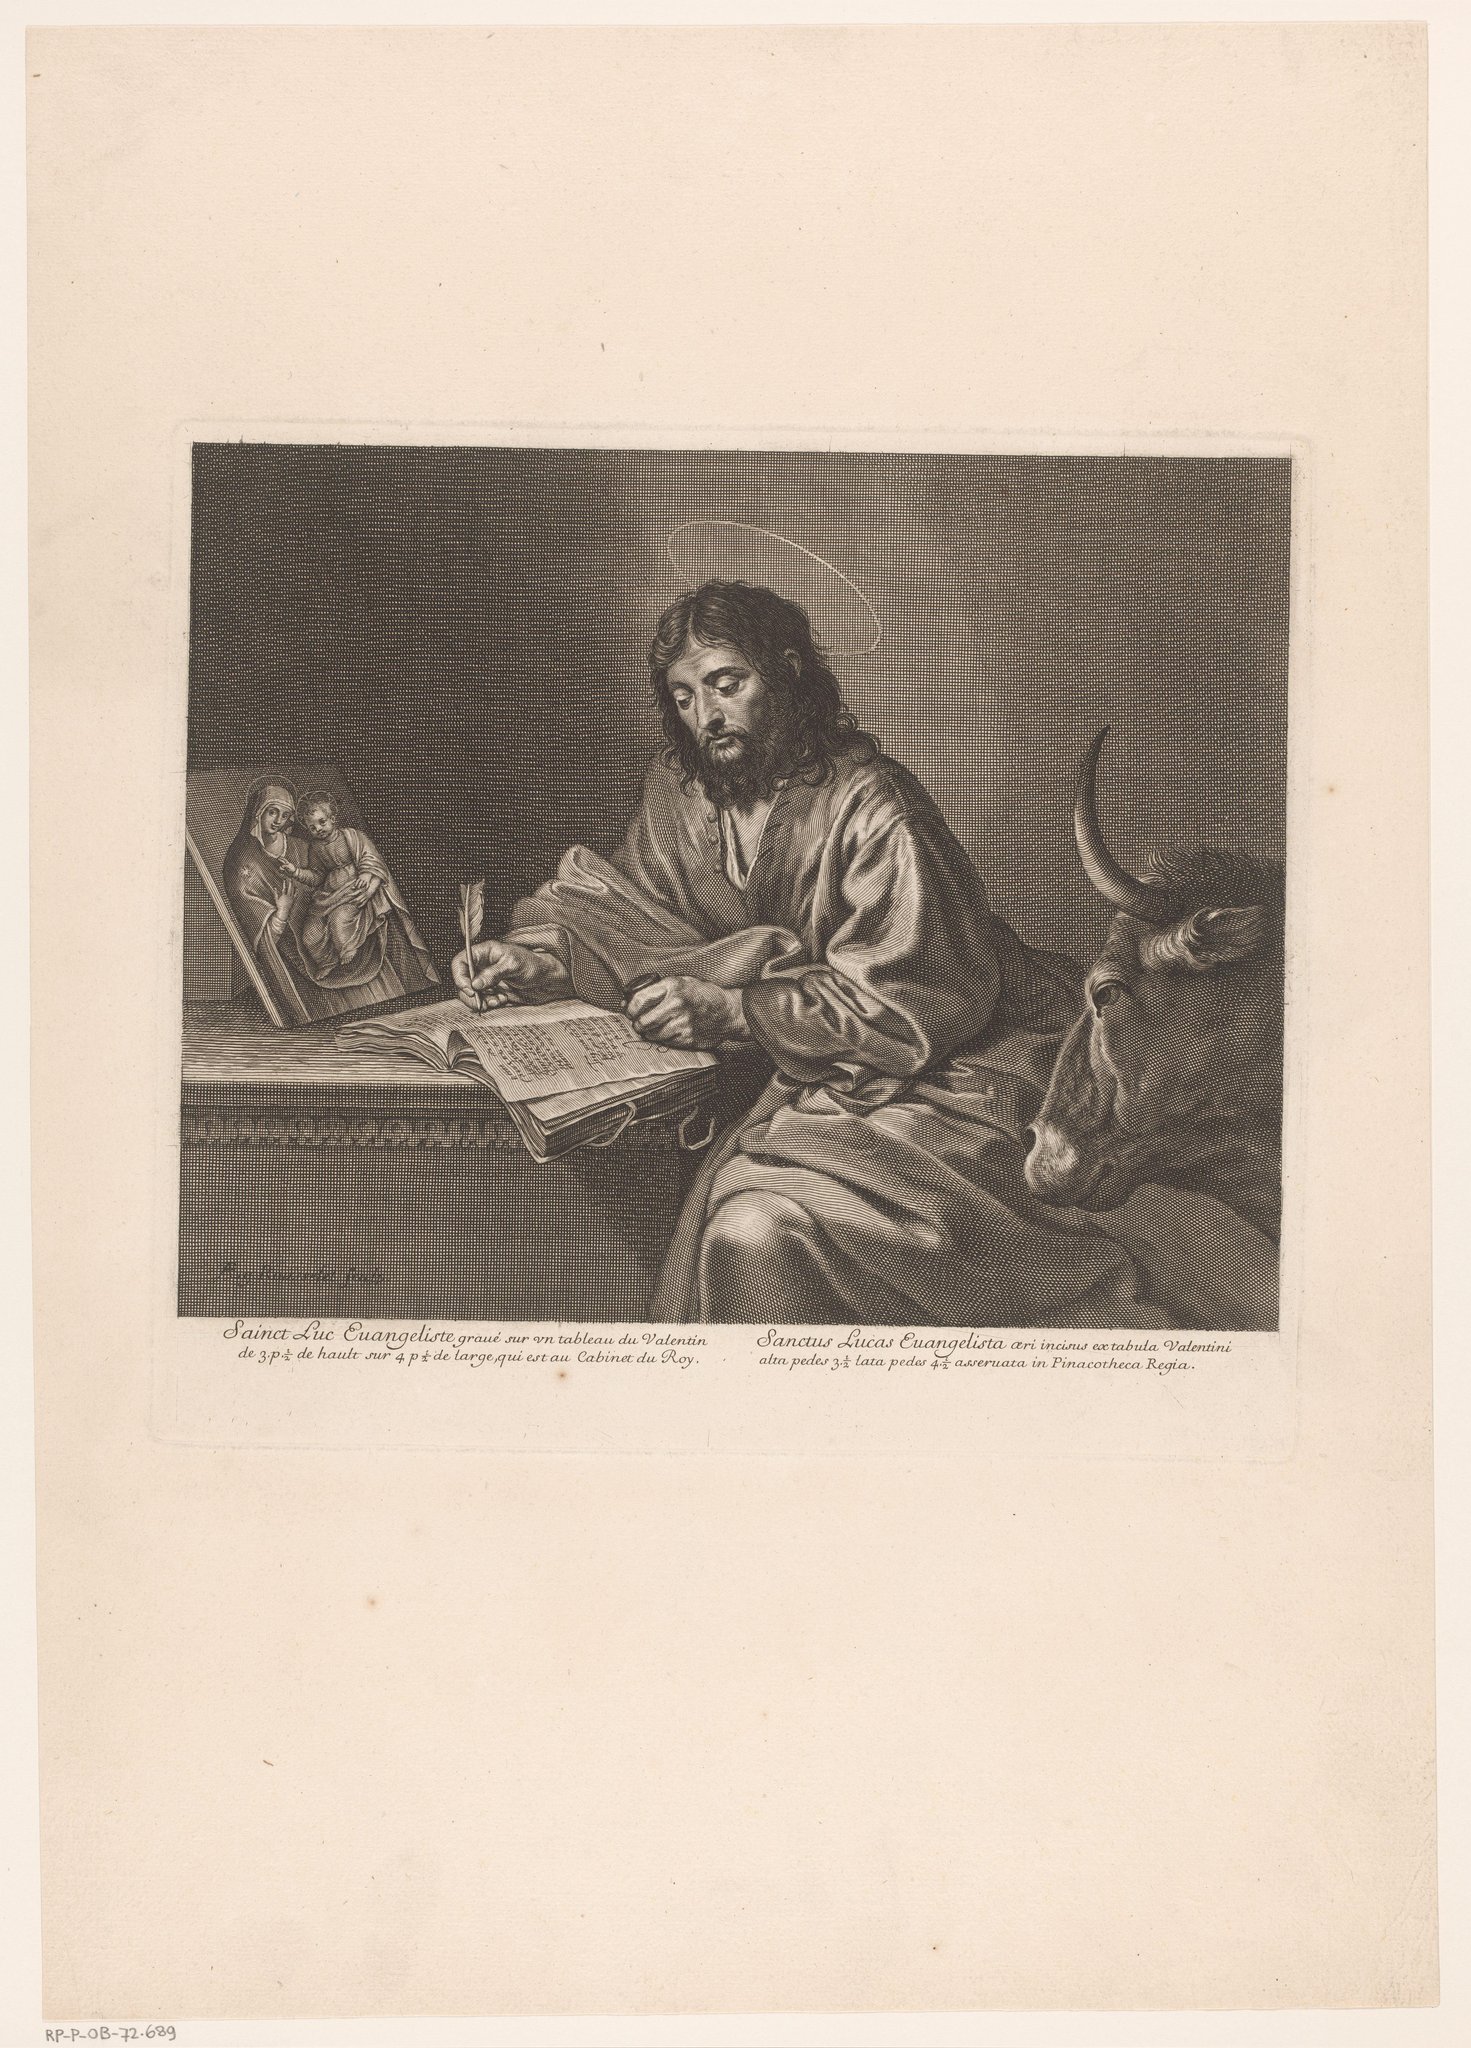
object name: print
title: Lucas de Evangelist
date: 1671-1672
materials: paper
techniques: engraving, etching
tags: luke the evangelist; possible attributes: book, (winged) ox, portrait of the virgin, surgical instruments, painter's utensils, scroll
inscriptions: collector's mark: Lugt 2228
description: Prent maakt deel uit van een ongenummerde serie van vier prenten.